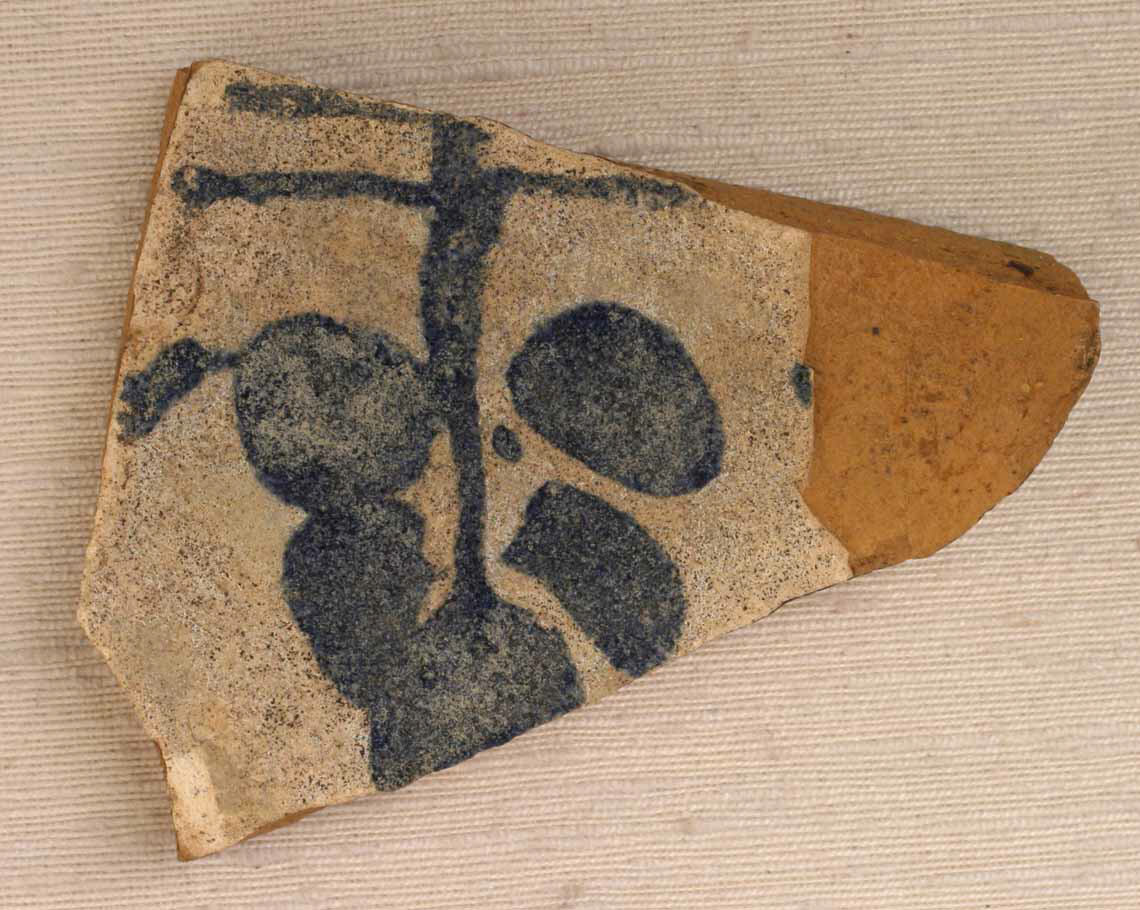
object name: fragment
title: Fragment of an Open Vessel with Blue Palmette on White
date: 801-900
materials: earthenware, glaze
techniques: painting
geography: iraq